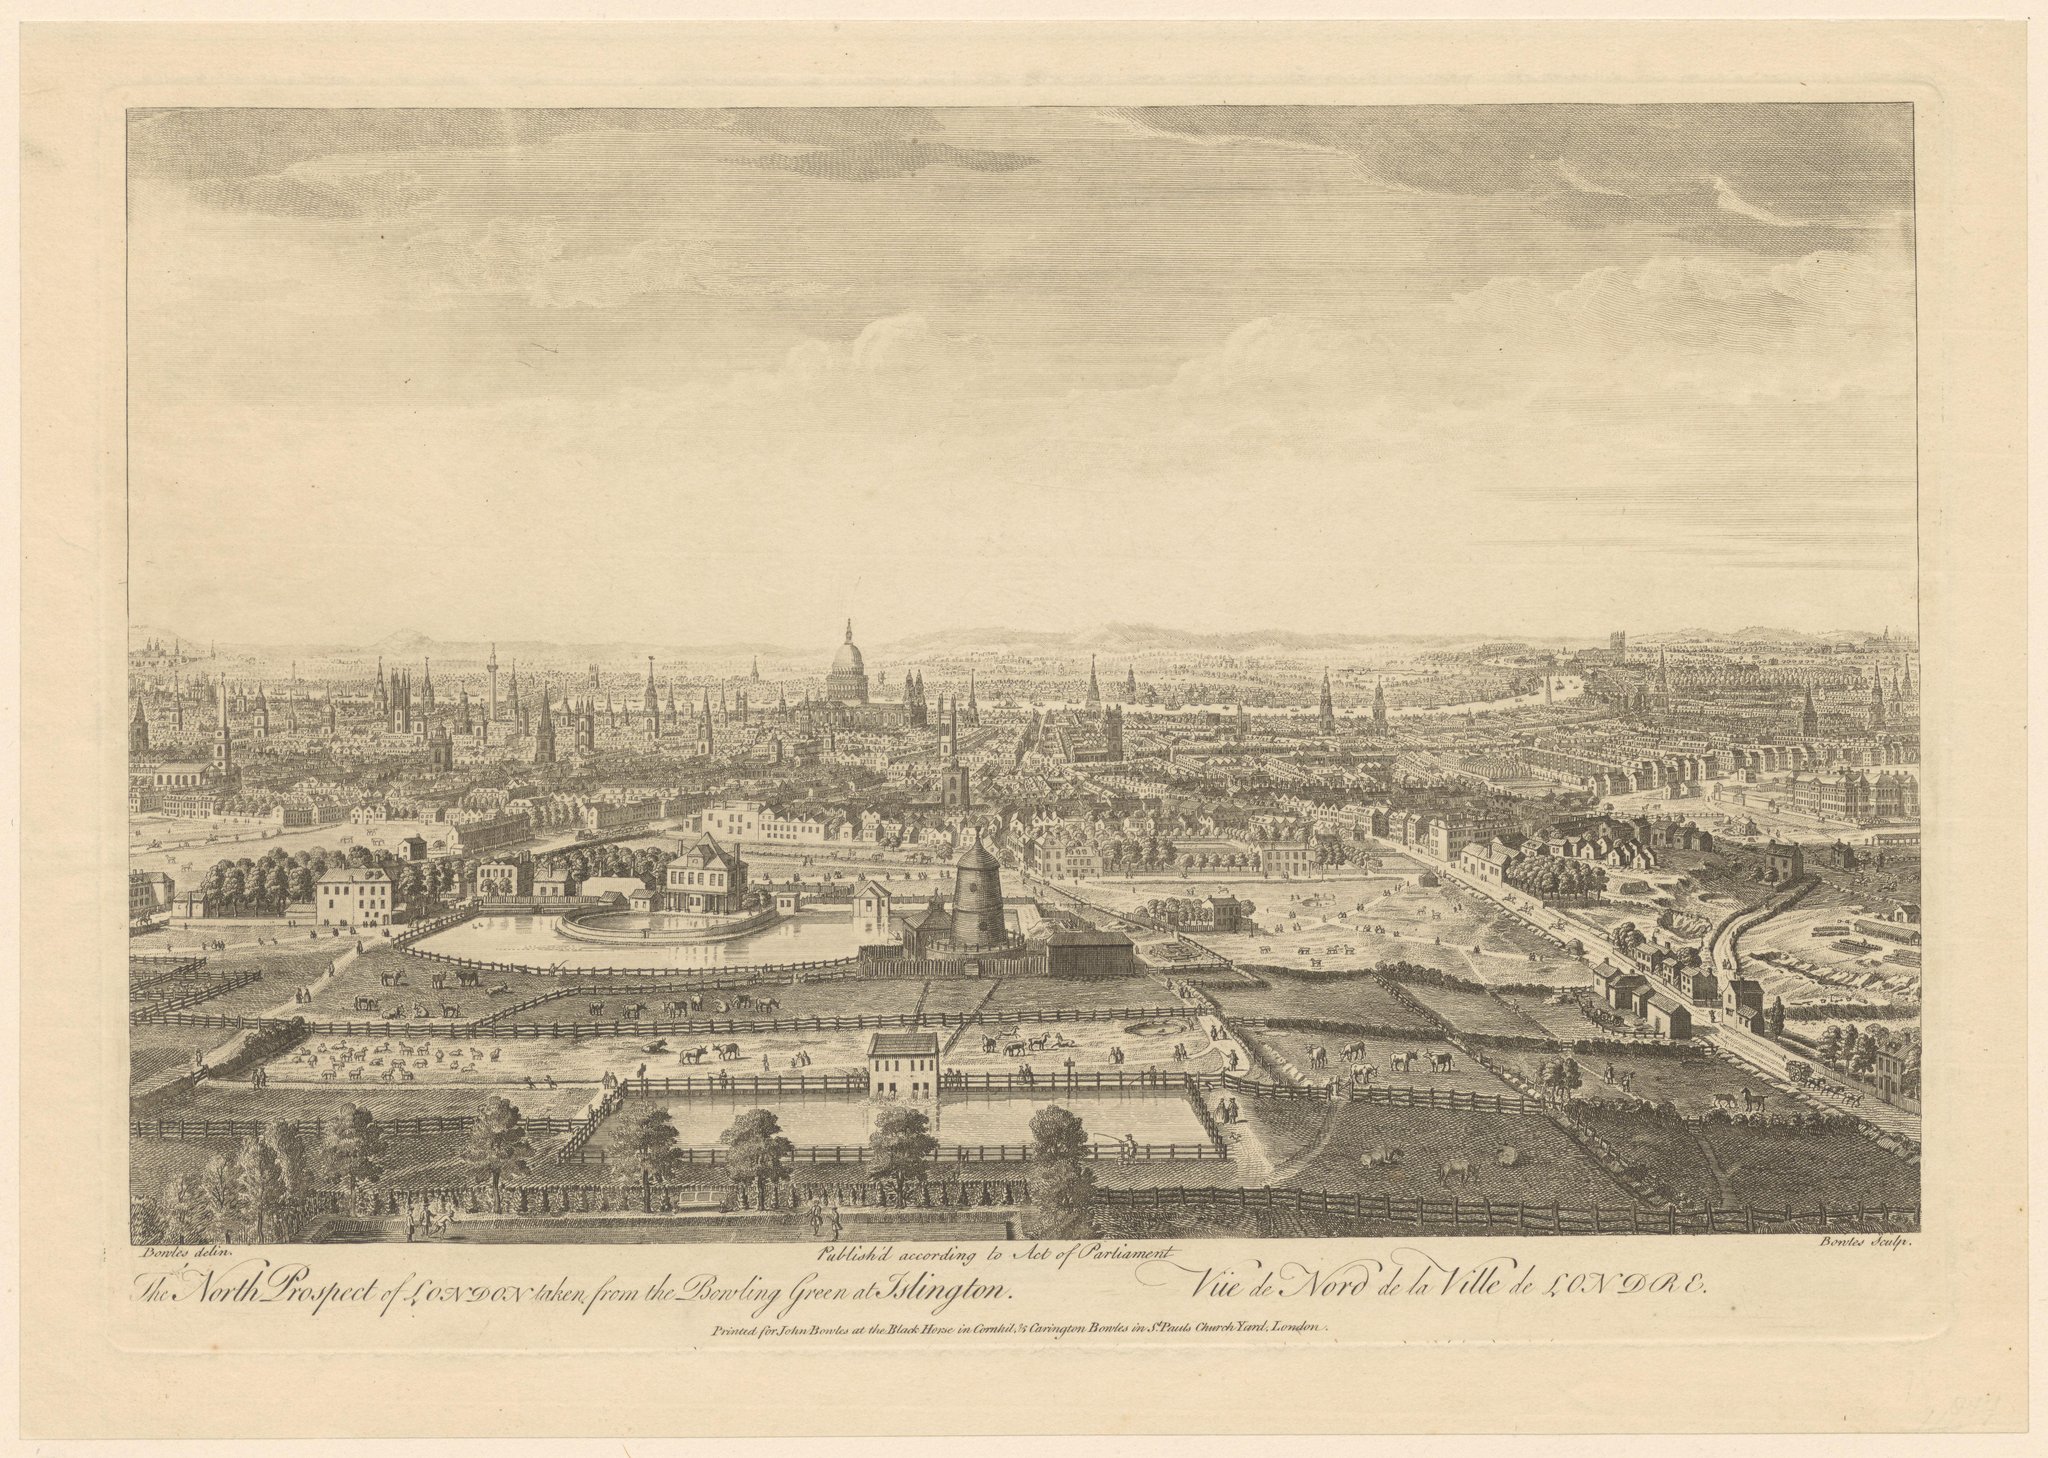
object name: print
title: The North Prospect of London taken from the Bowling Green at Islington / Vüe de Nord de la Ville de Londre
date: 1752-1766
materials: paper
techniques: engraving, etching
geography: london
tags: city-view, and landscape with man-made constructions, london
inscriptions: collector's mark: Lugt 2228